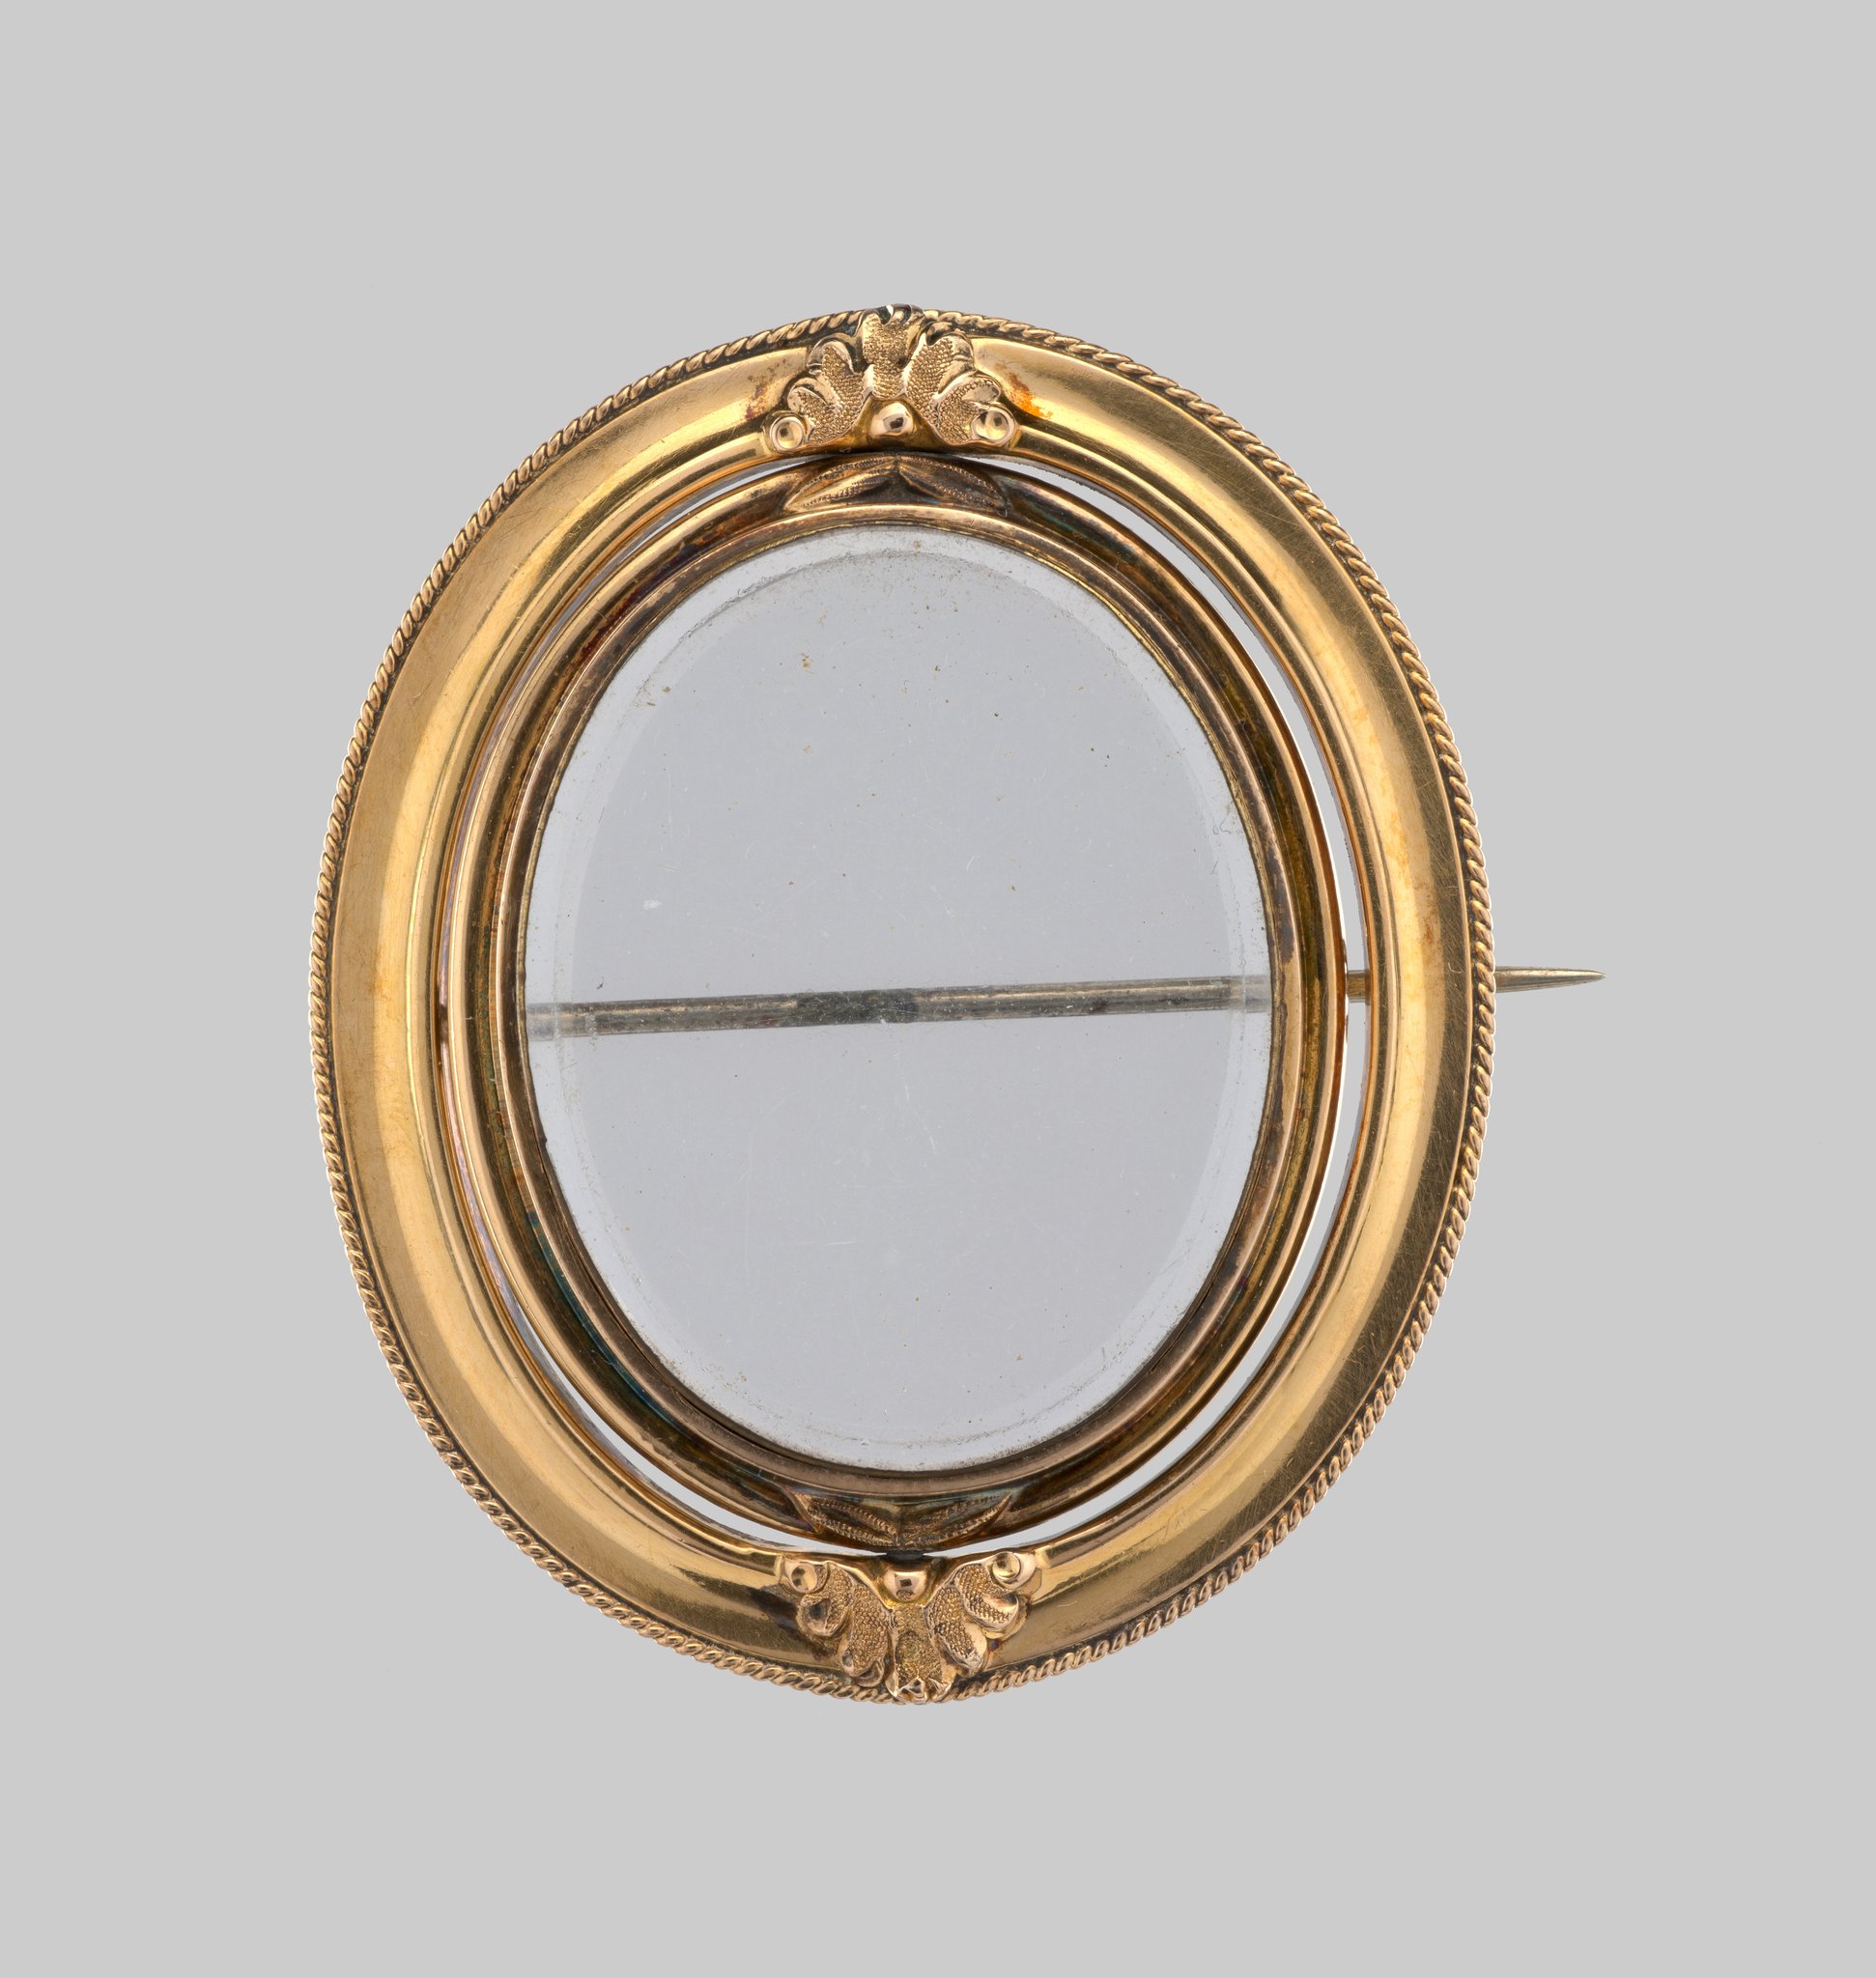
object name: brooch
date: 1801-1900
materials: gold